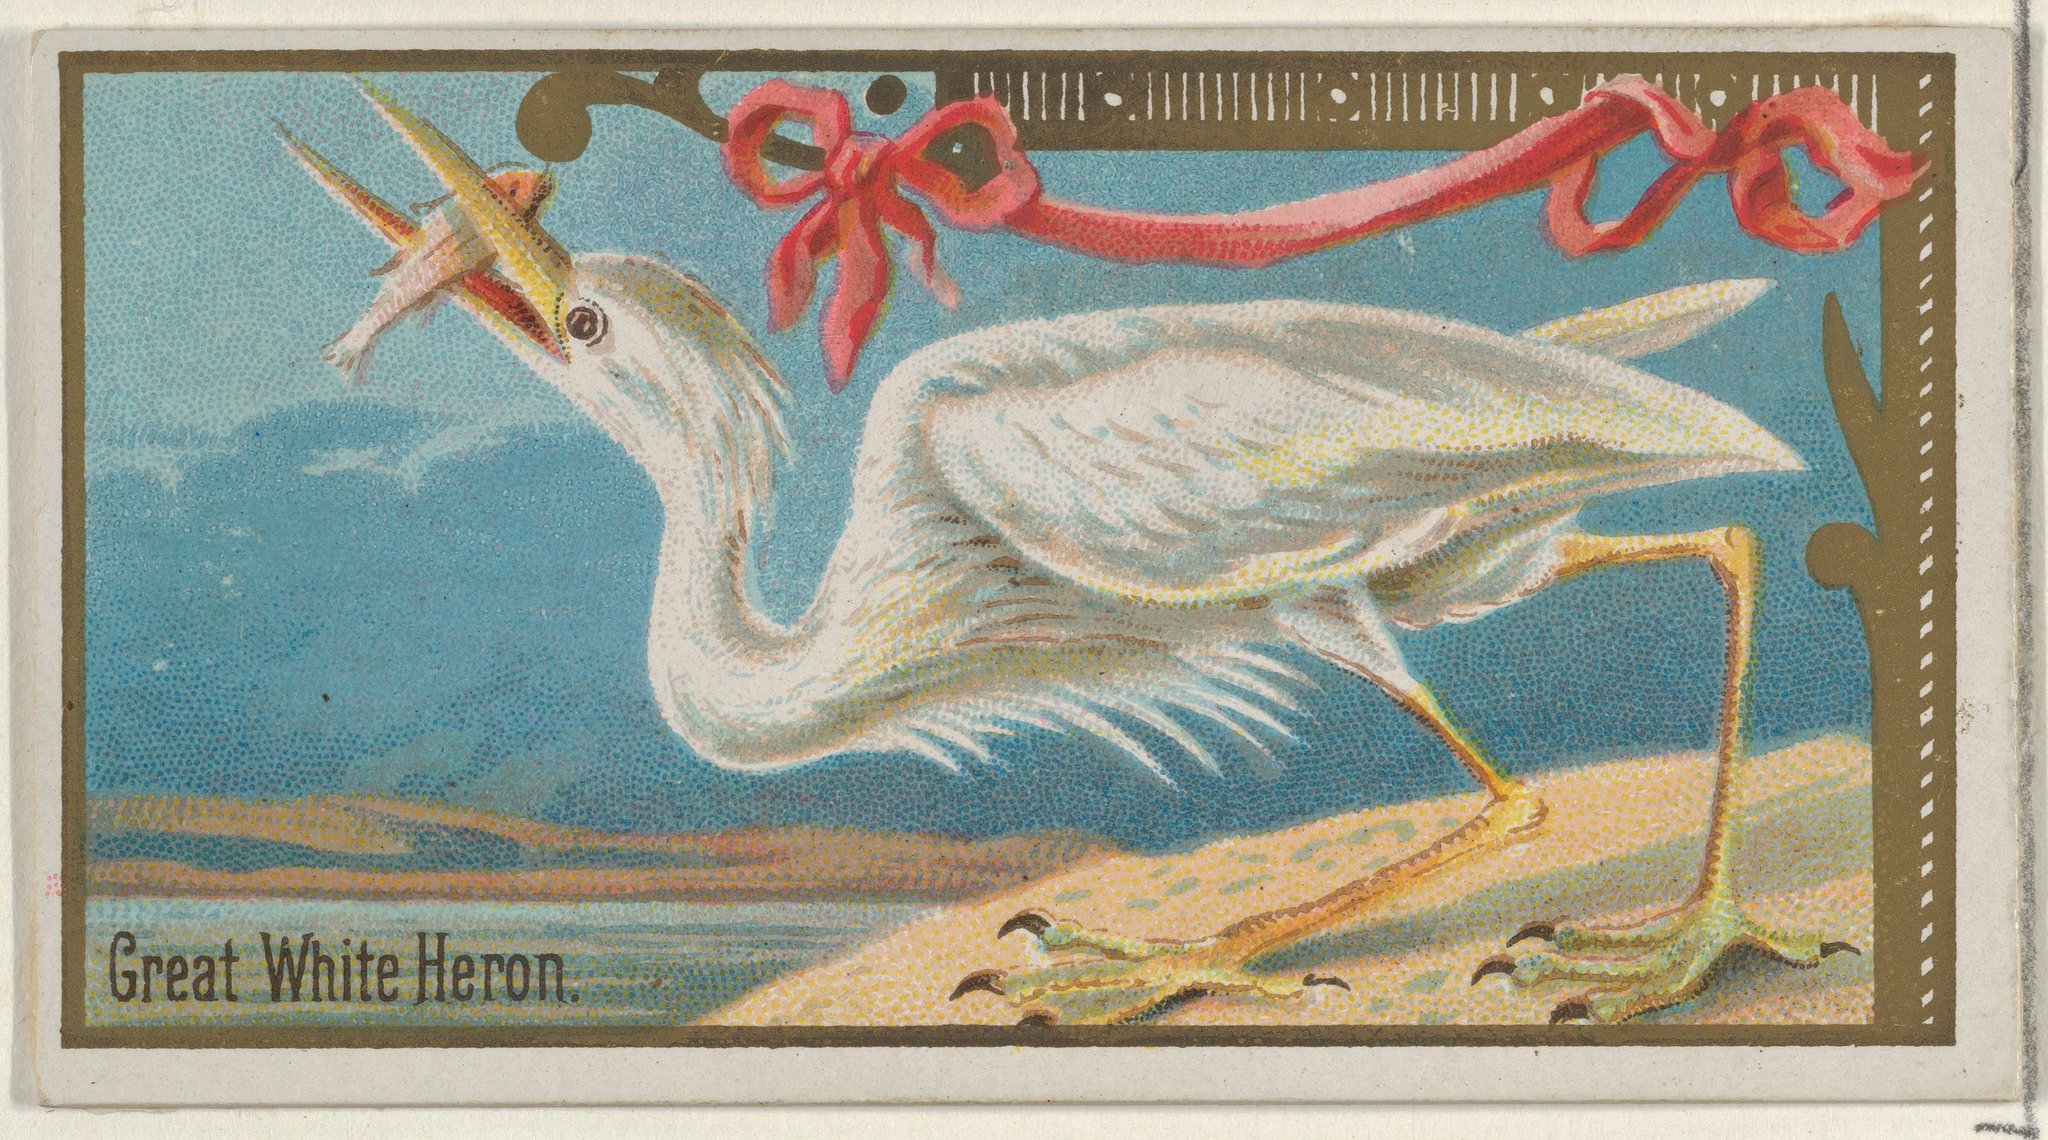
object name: print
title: Great White Heron, from the Game Birds series (N13) for Allen & Ginter Cigarettes Brands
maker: allen & ginter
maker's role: publisher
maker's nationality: american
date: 1889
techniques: color lithograph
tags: birds